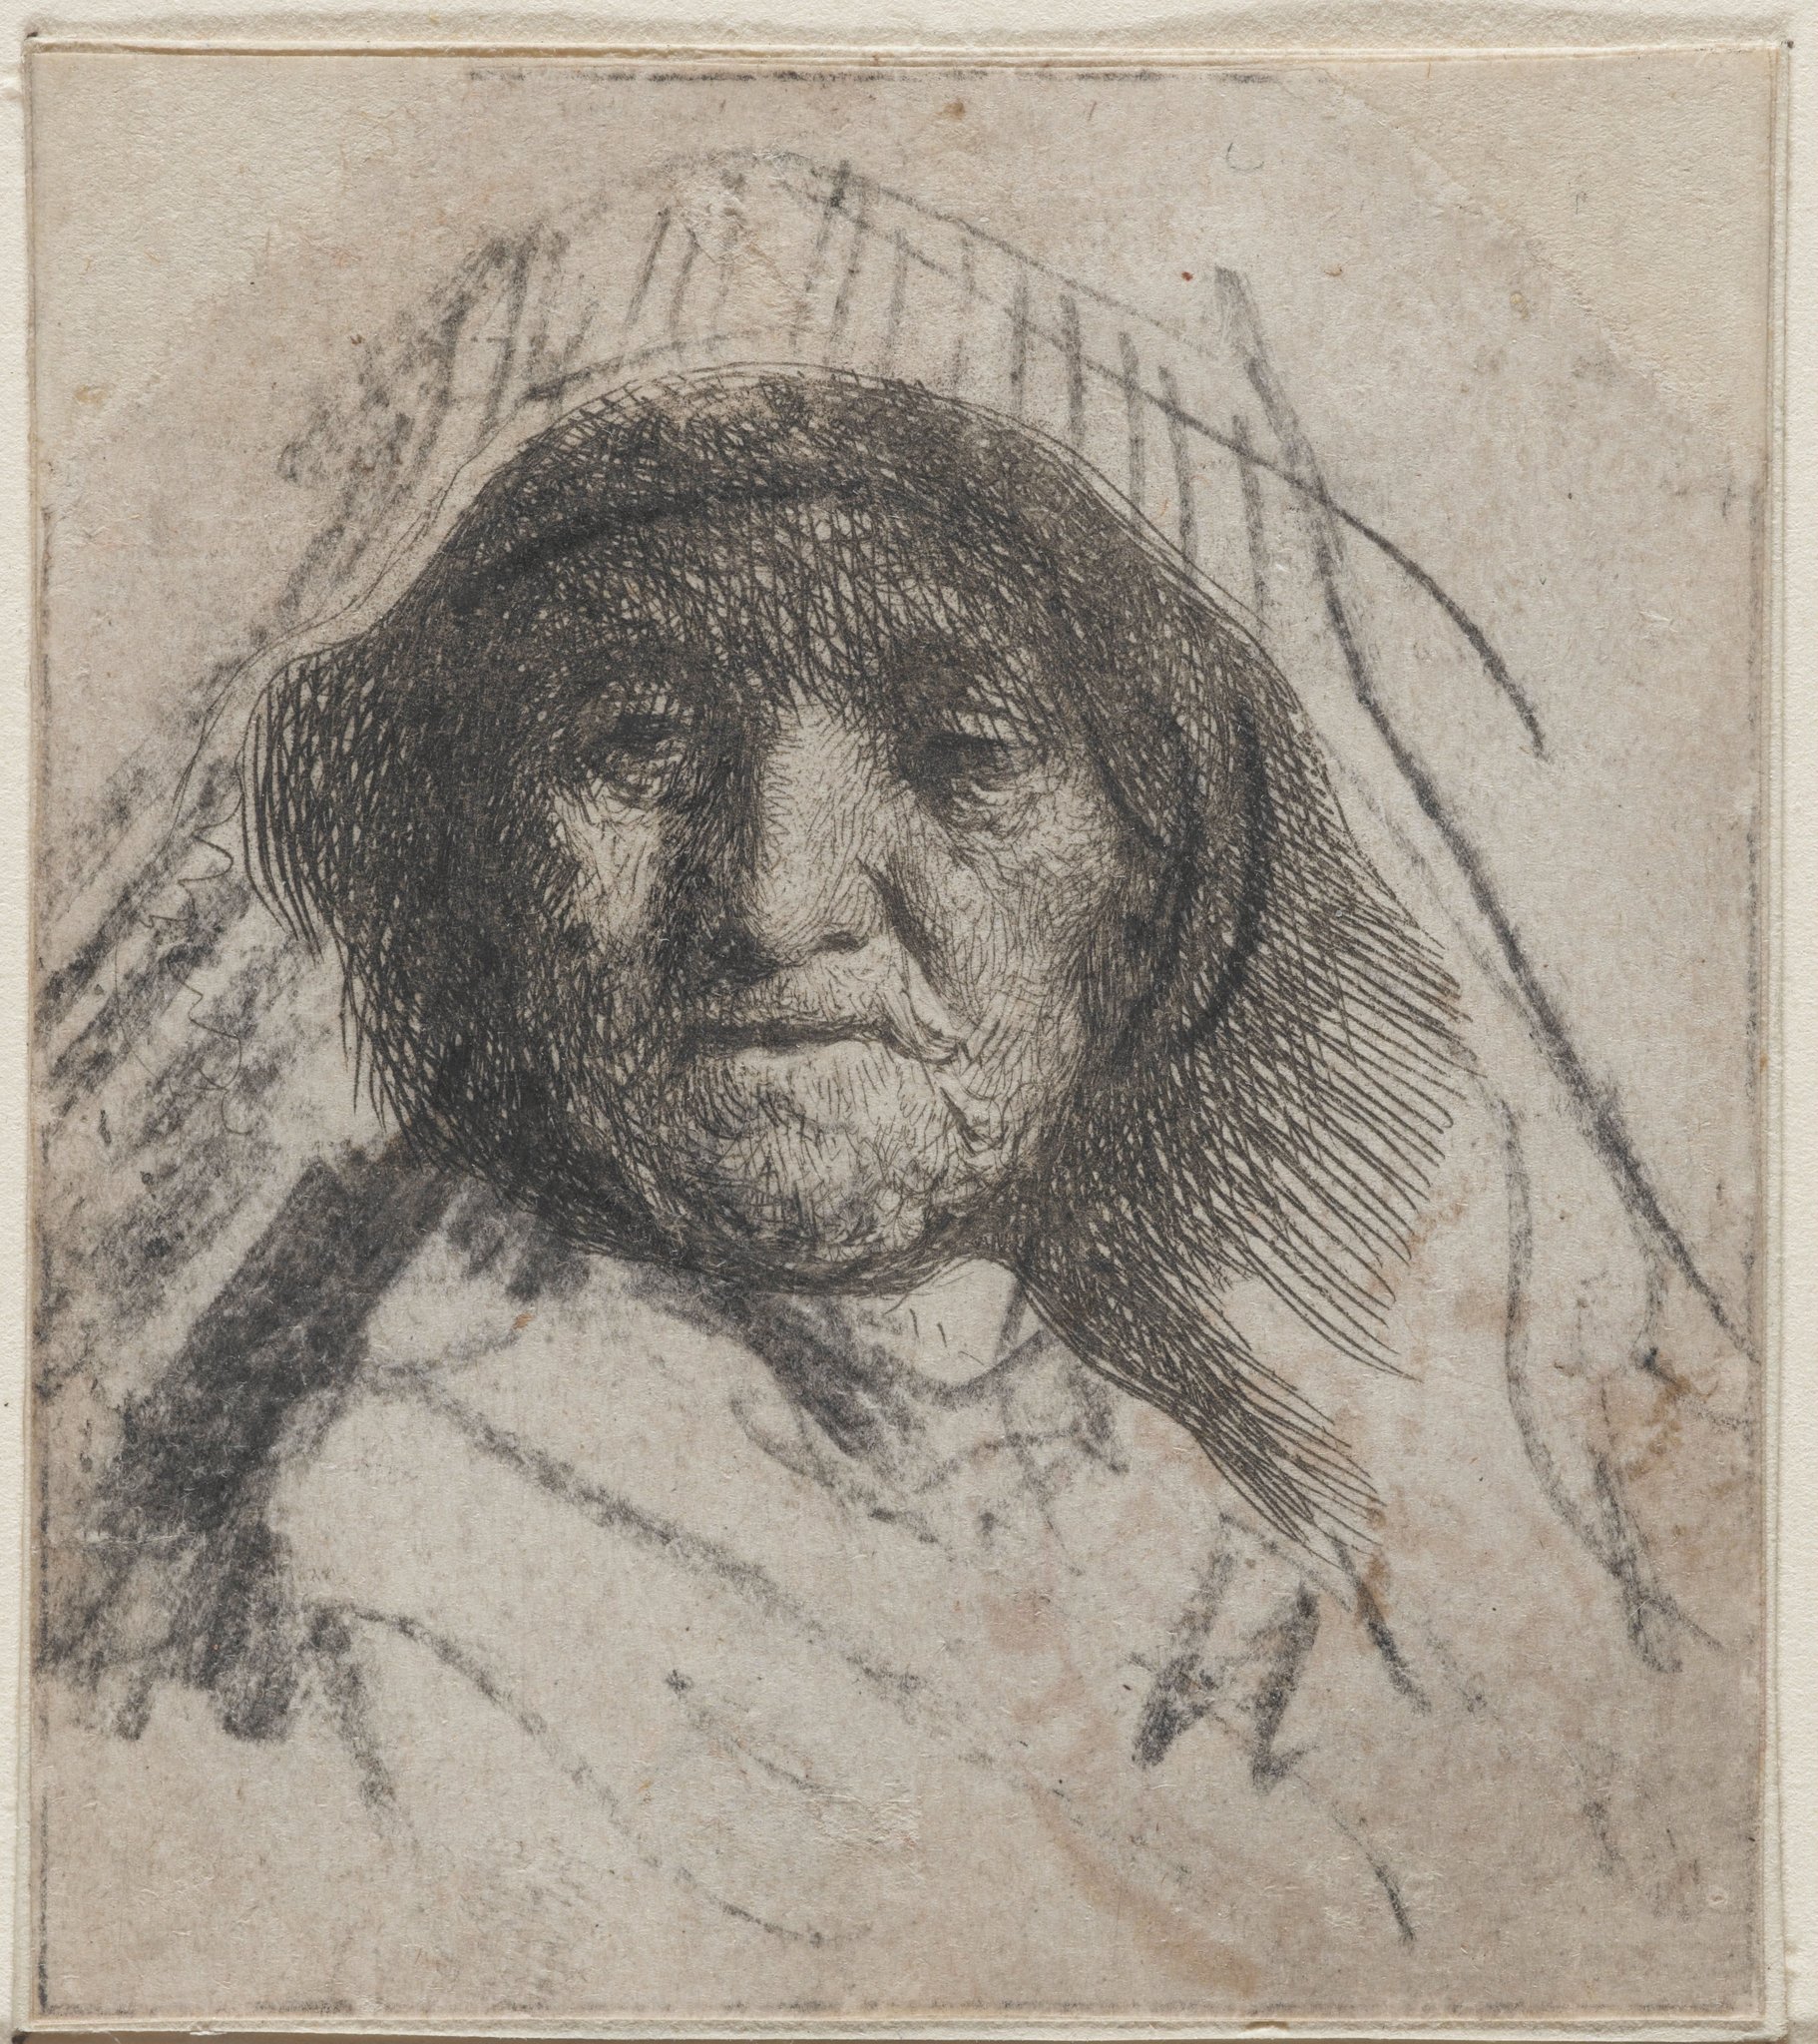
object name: print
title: The artist's mother: head only, full face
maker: rembrandt van rijn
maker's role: draughtsman, painter, print maker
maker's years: 1606-1669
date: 1628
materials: chalk, paper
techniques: etching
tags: neeltje willemsdr. zuytbrouck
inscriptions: collector's mark: Lugt 240, collector's mark: Lugt 2165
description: This old woman already featured in the first etchings Rembrandt made. She is virtually certainly his mother, Neeltgen Willemsdr van Zuytbroeck. In the two versions of 1628, she is 60 years old. They are accurate studies of her furrowed face, drawn in such detail that you can just imagine the young Rembrandt toiling away on his copperplate directly in front of her.